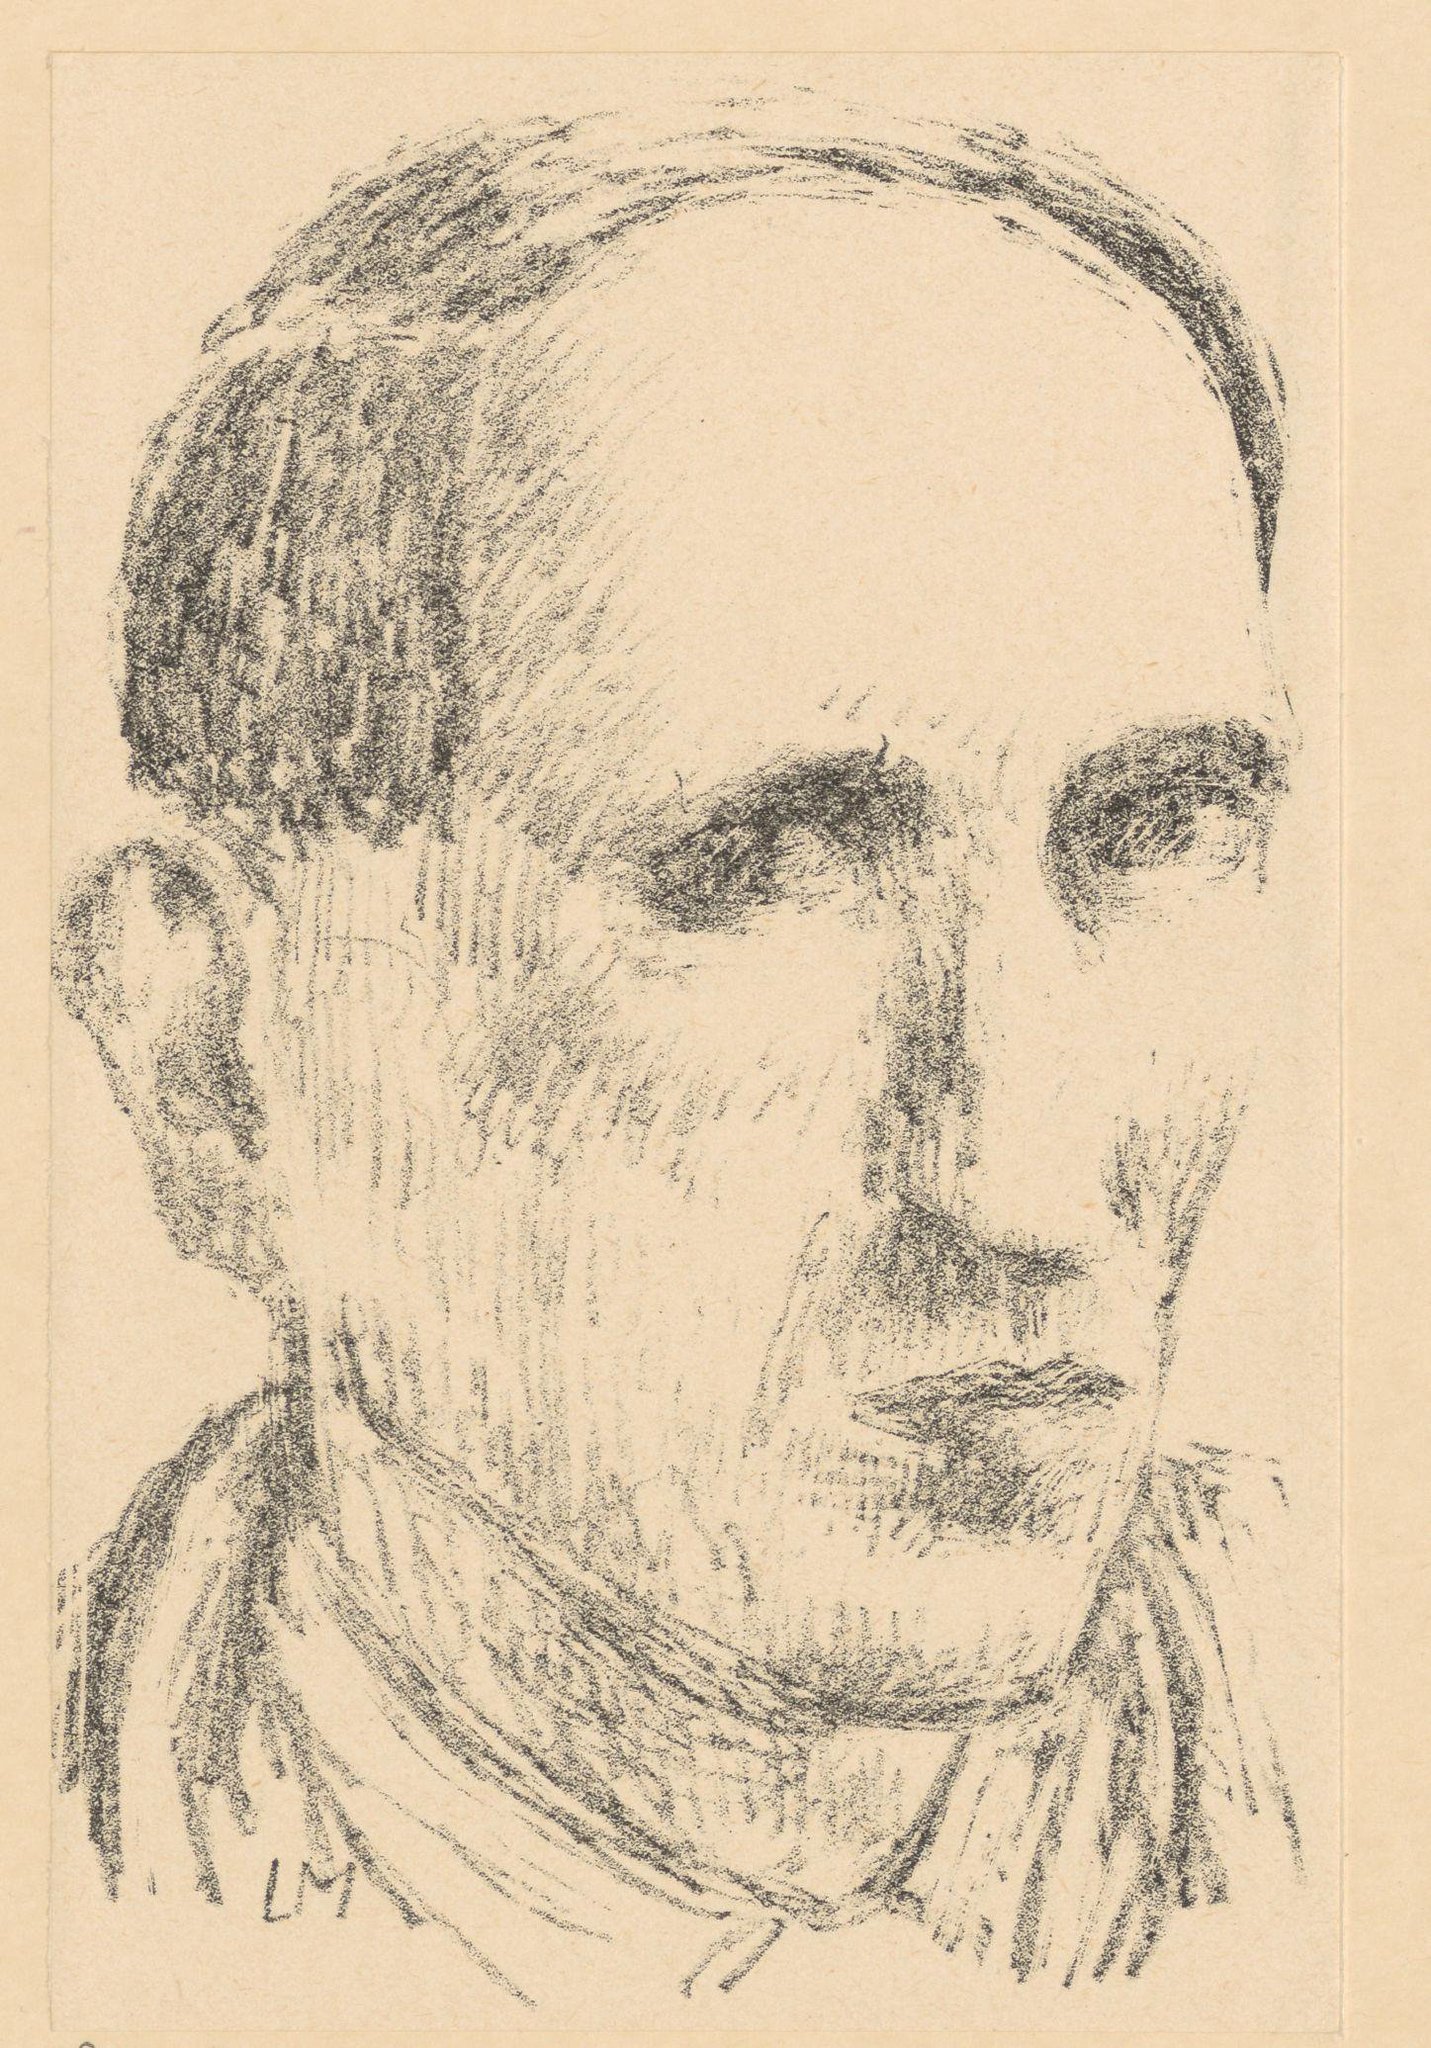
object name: print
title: Portret van een onbekende man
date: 1946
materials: paper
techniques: lithograph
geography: geneva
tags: historical persons not known by name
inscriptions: date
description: Prent uit: Eugène, Martin. Vernissages. Genève: Pierre Cailler, 1946.